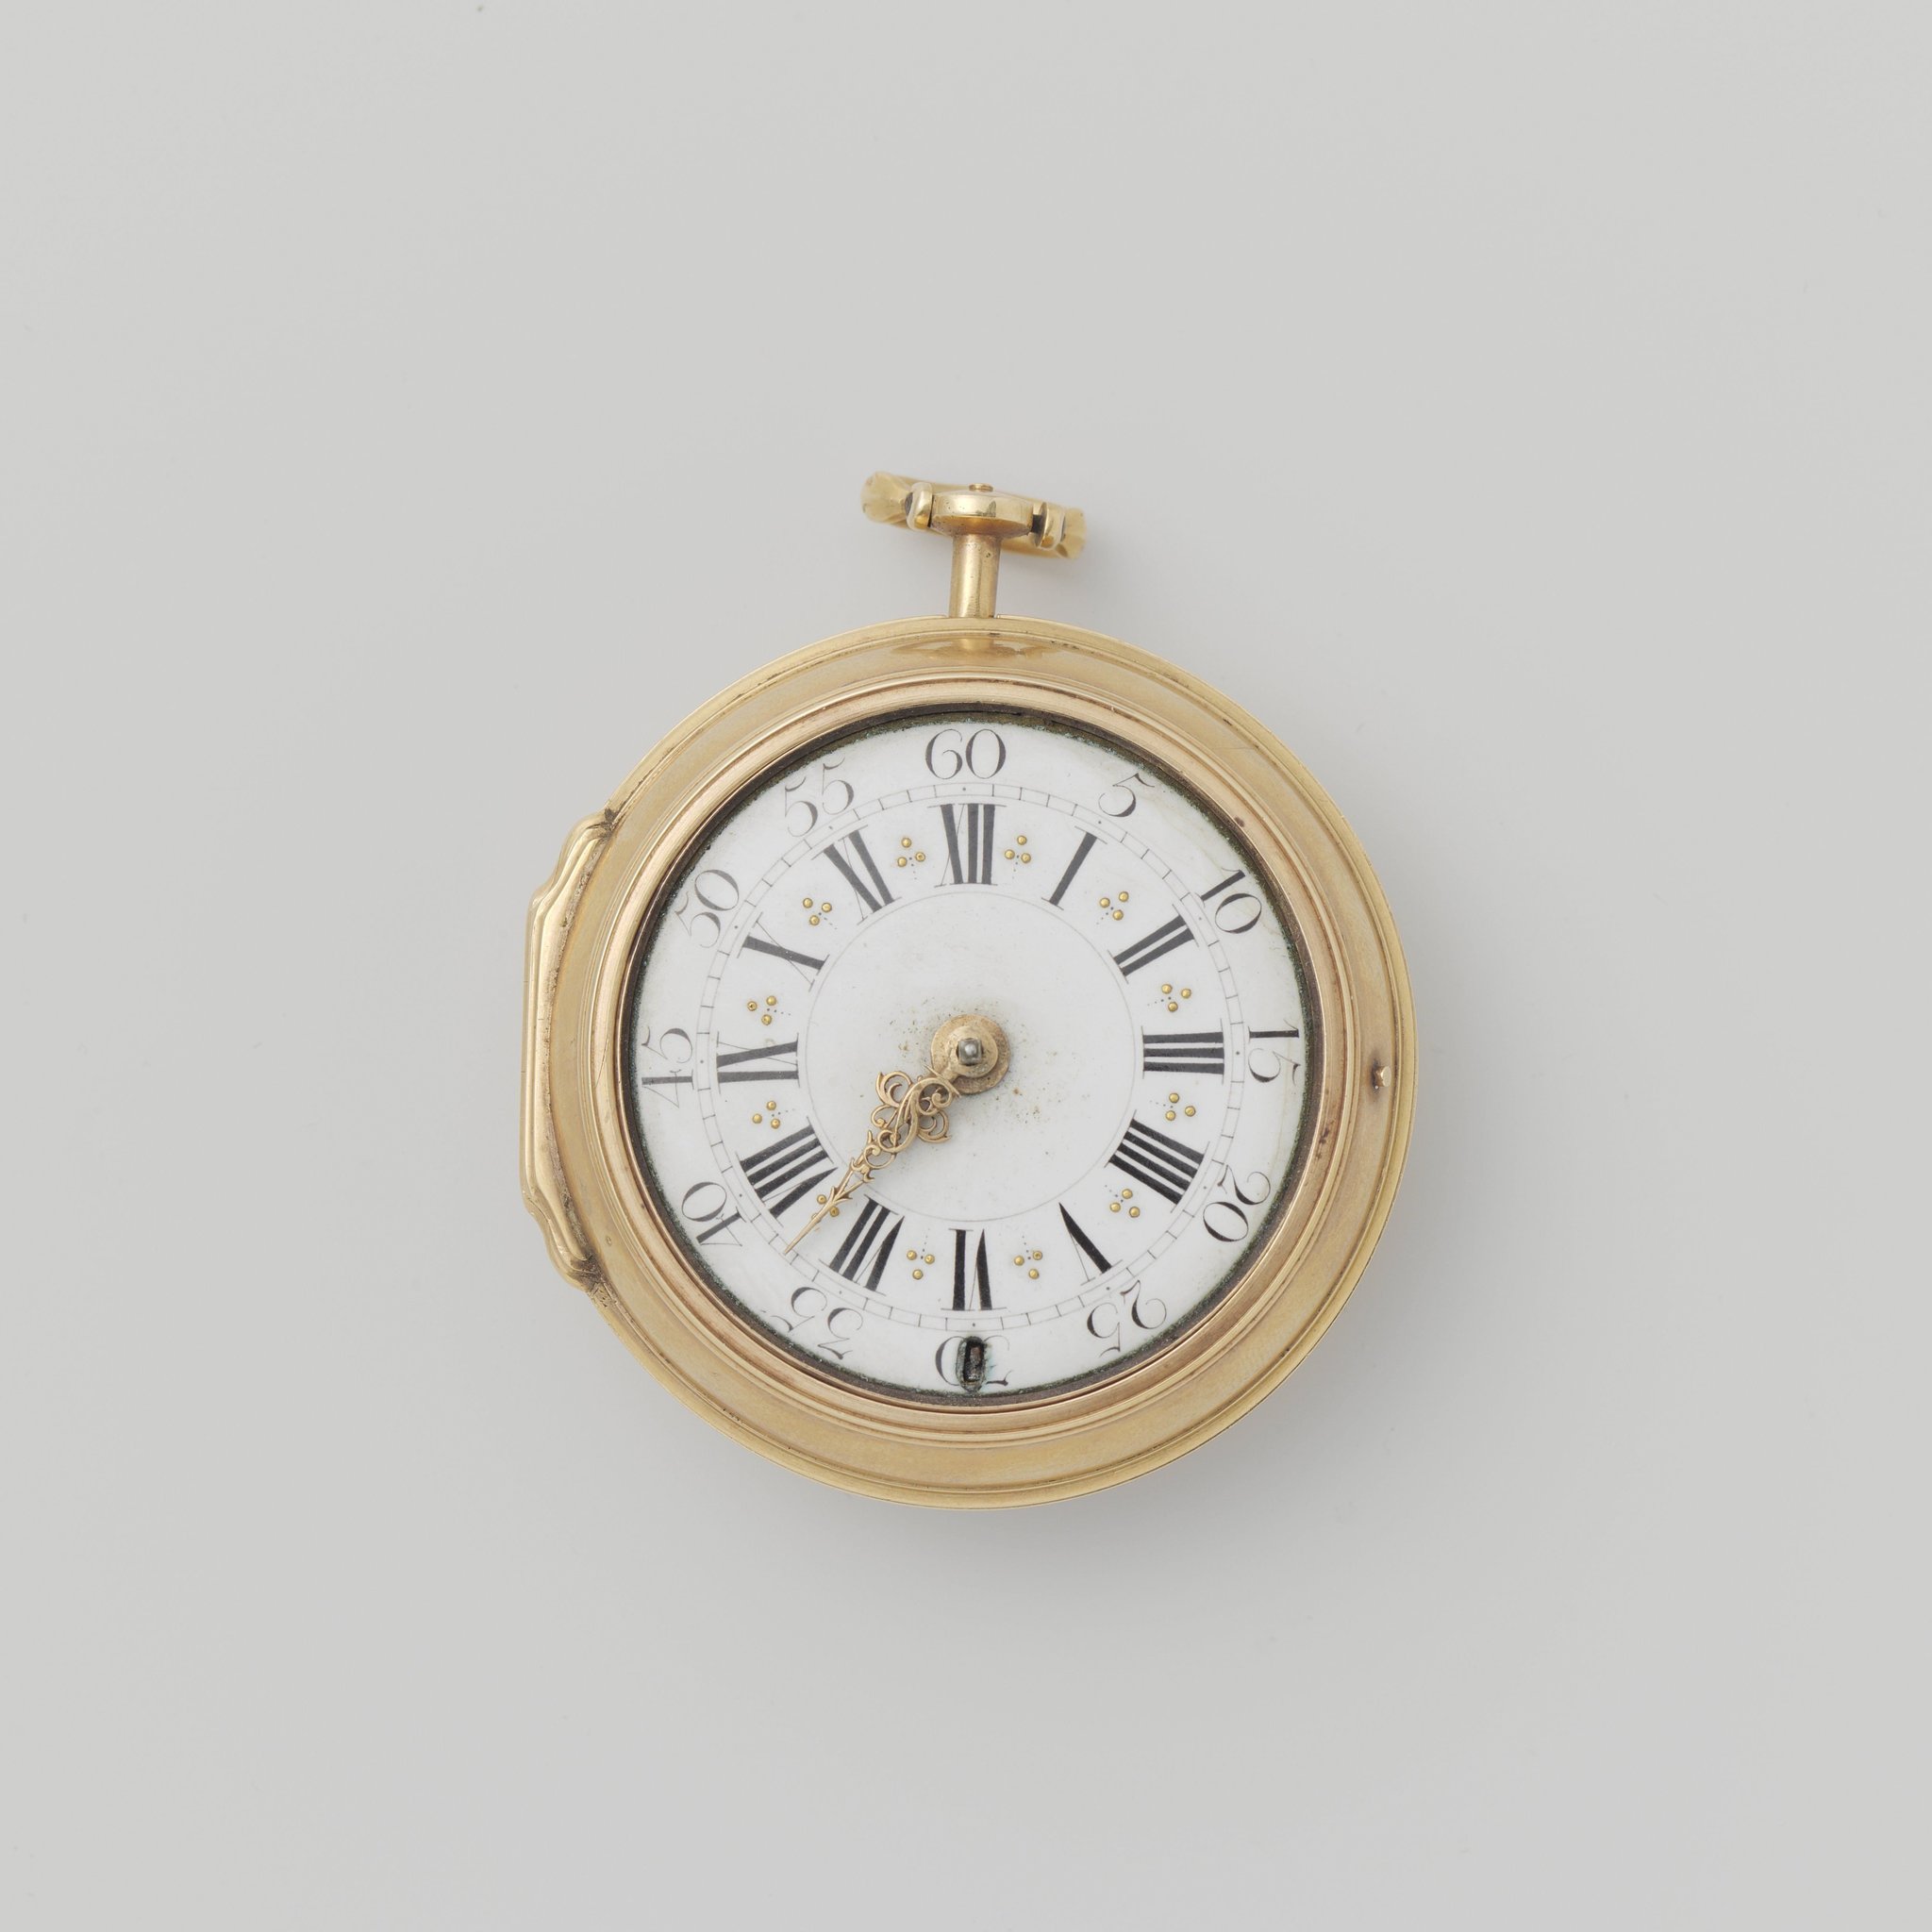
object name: jewellery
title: Watch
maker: Anonymous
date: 1750-1775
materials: gold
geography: geneva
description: Horloge van goud met gladde kast. De wijzerplaat is geëmailleerd.